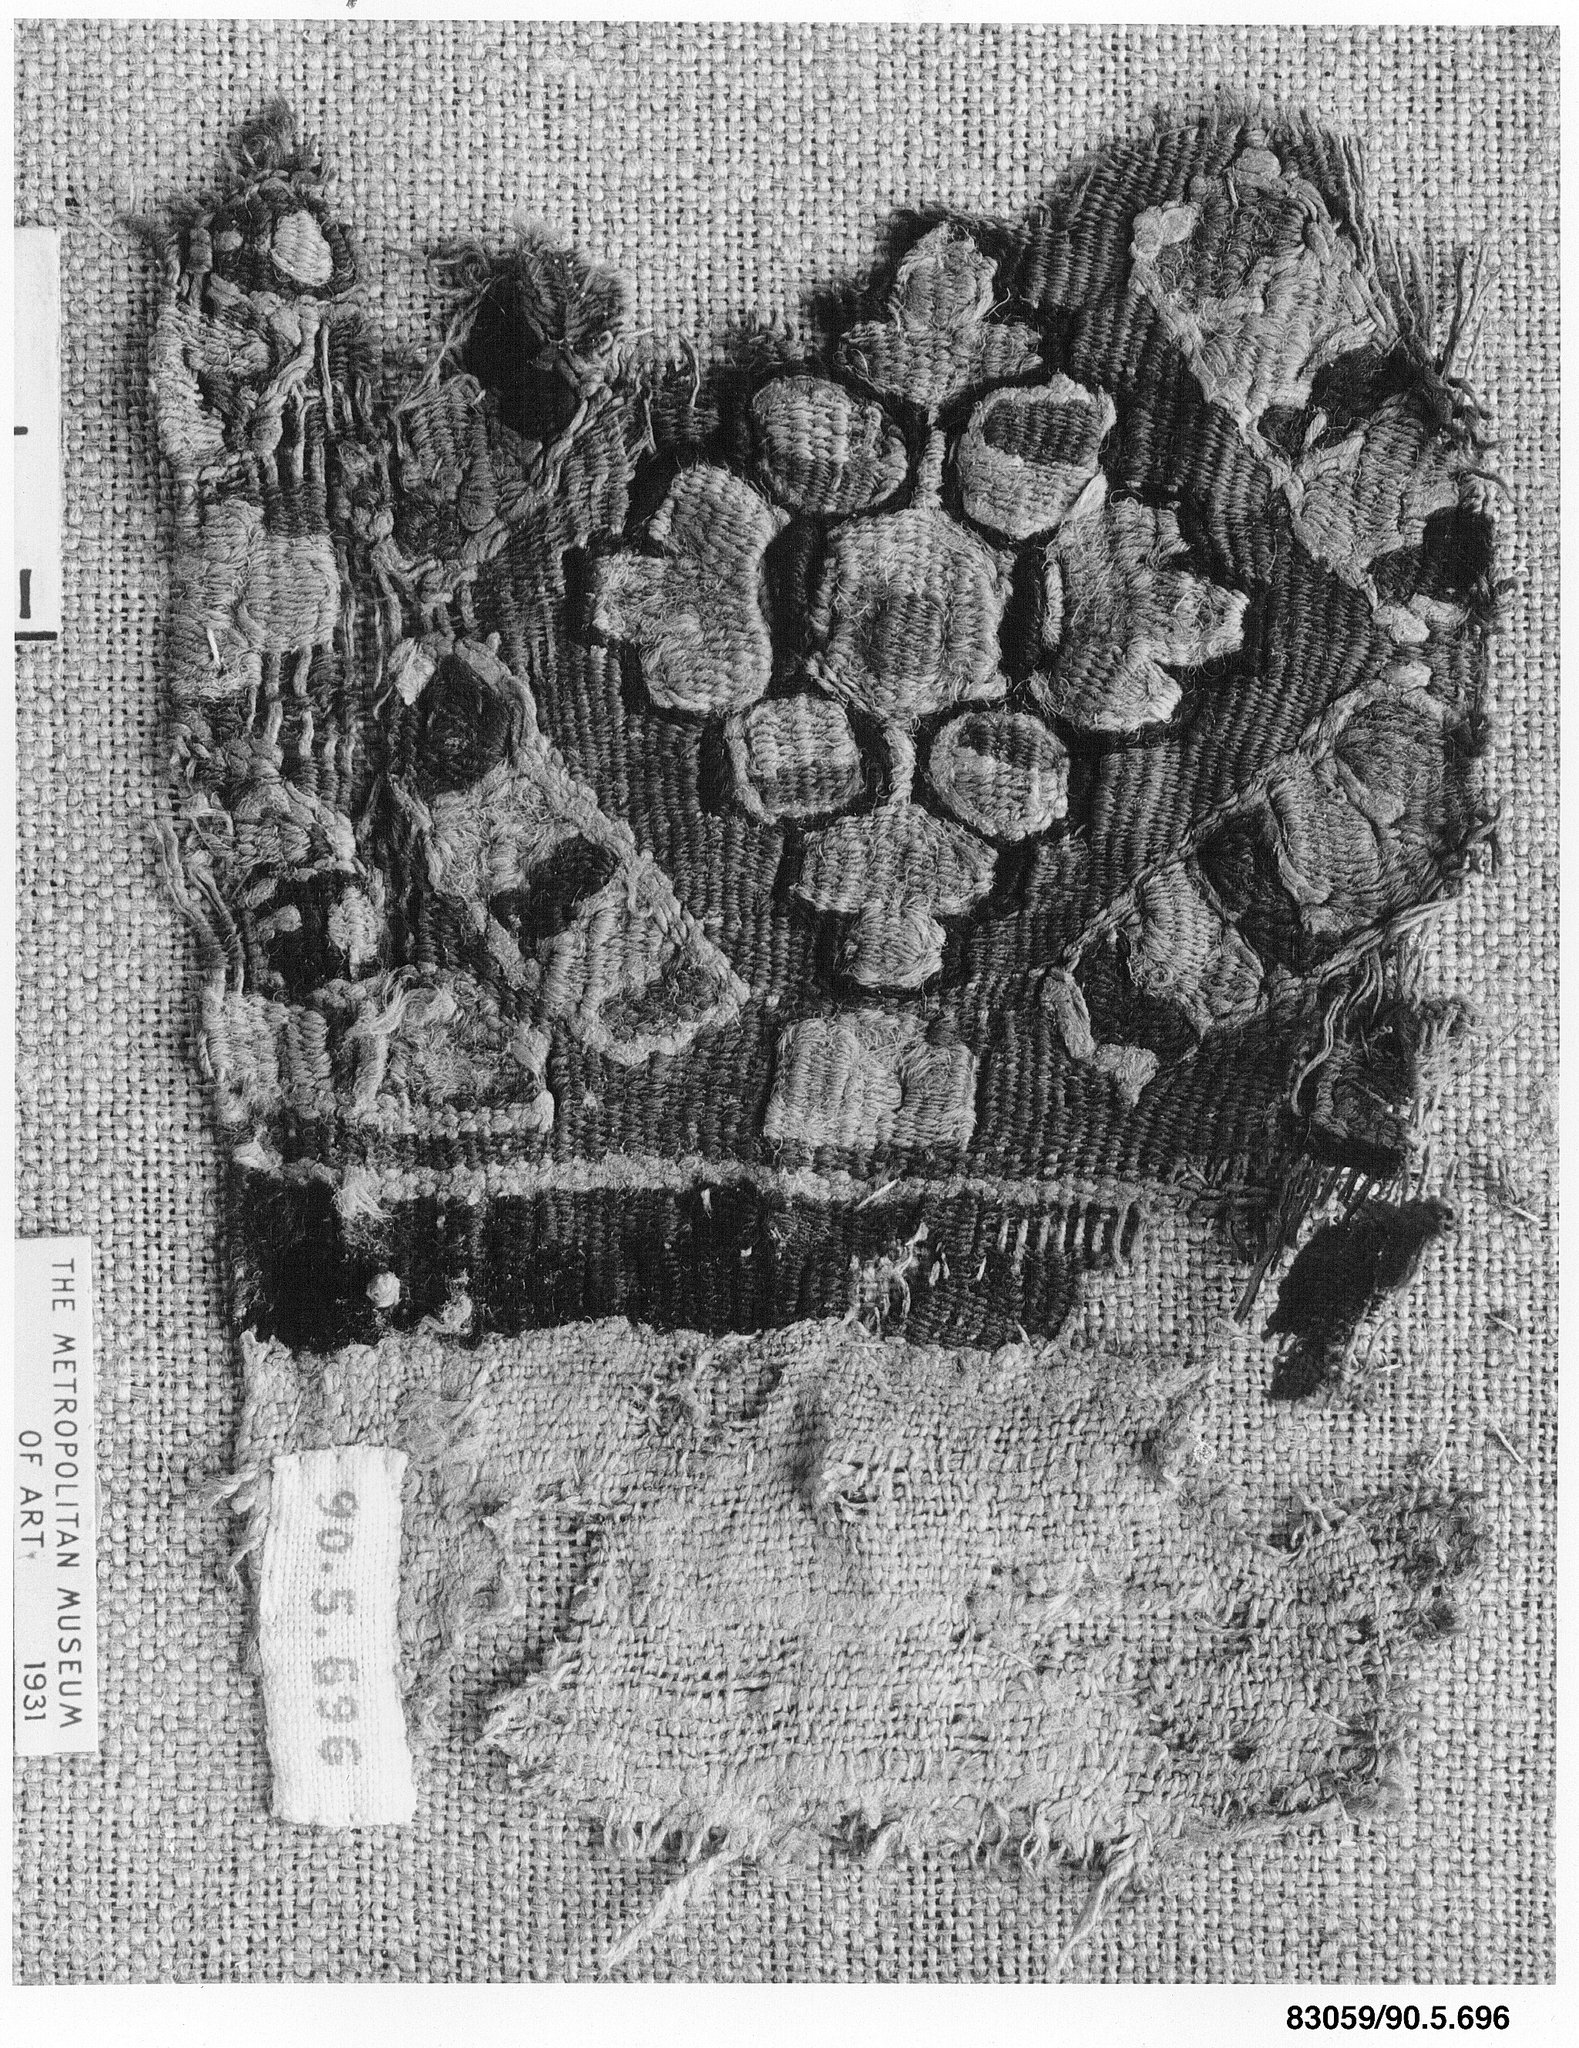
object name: textile fragment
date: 501-600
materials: linen, wool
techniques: weave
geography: egypt